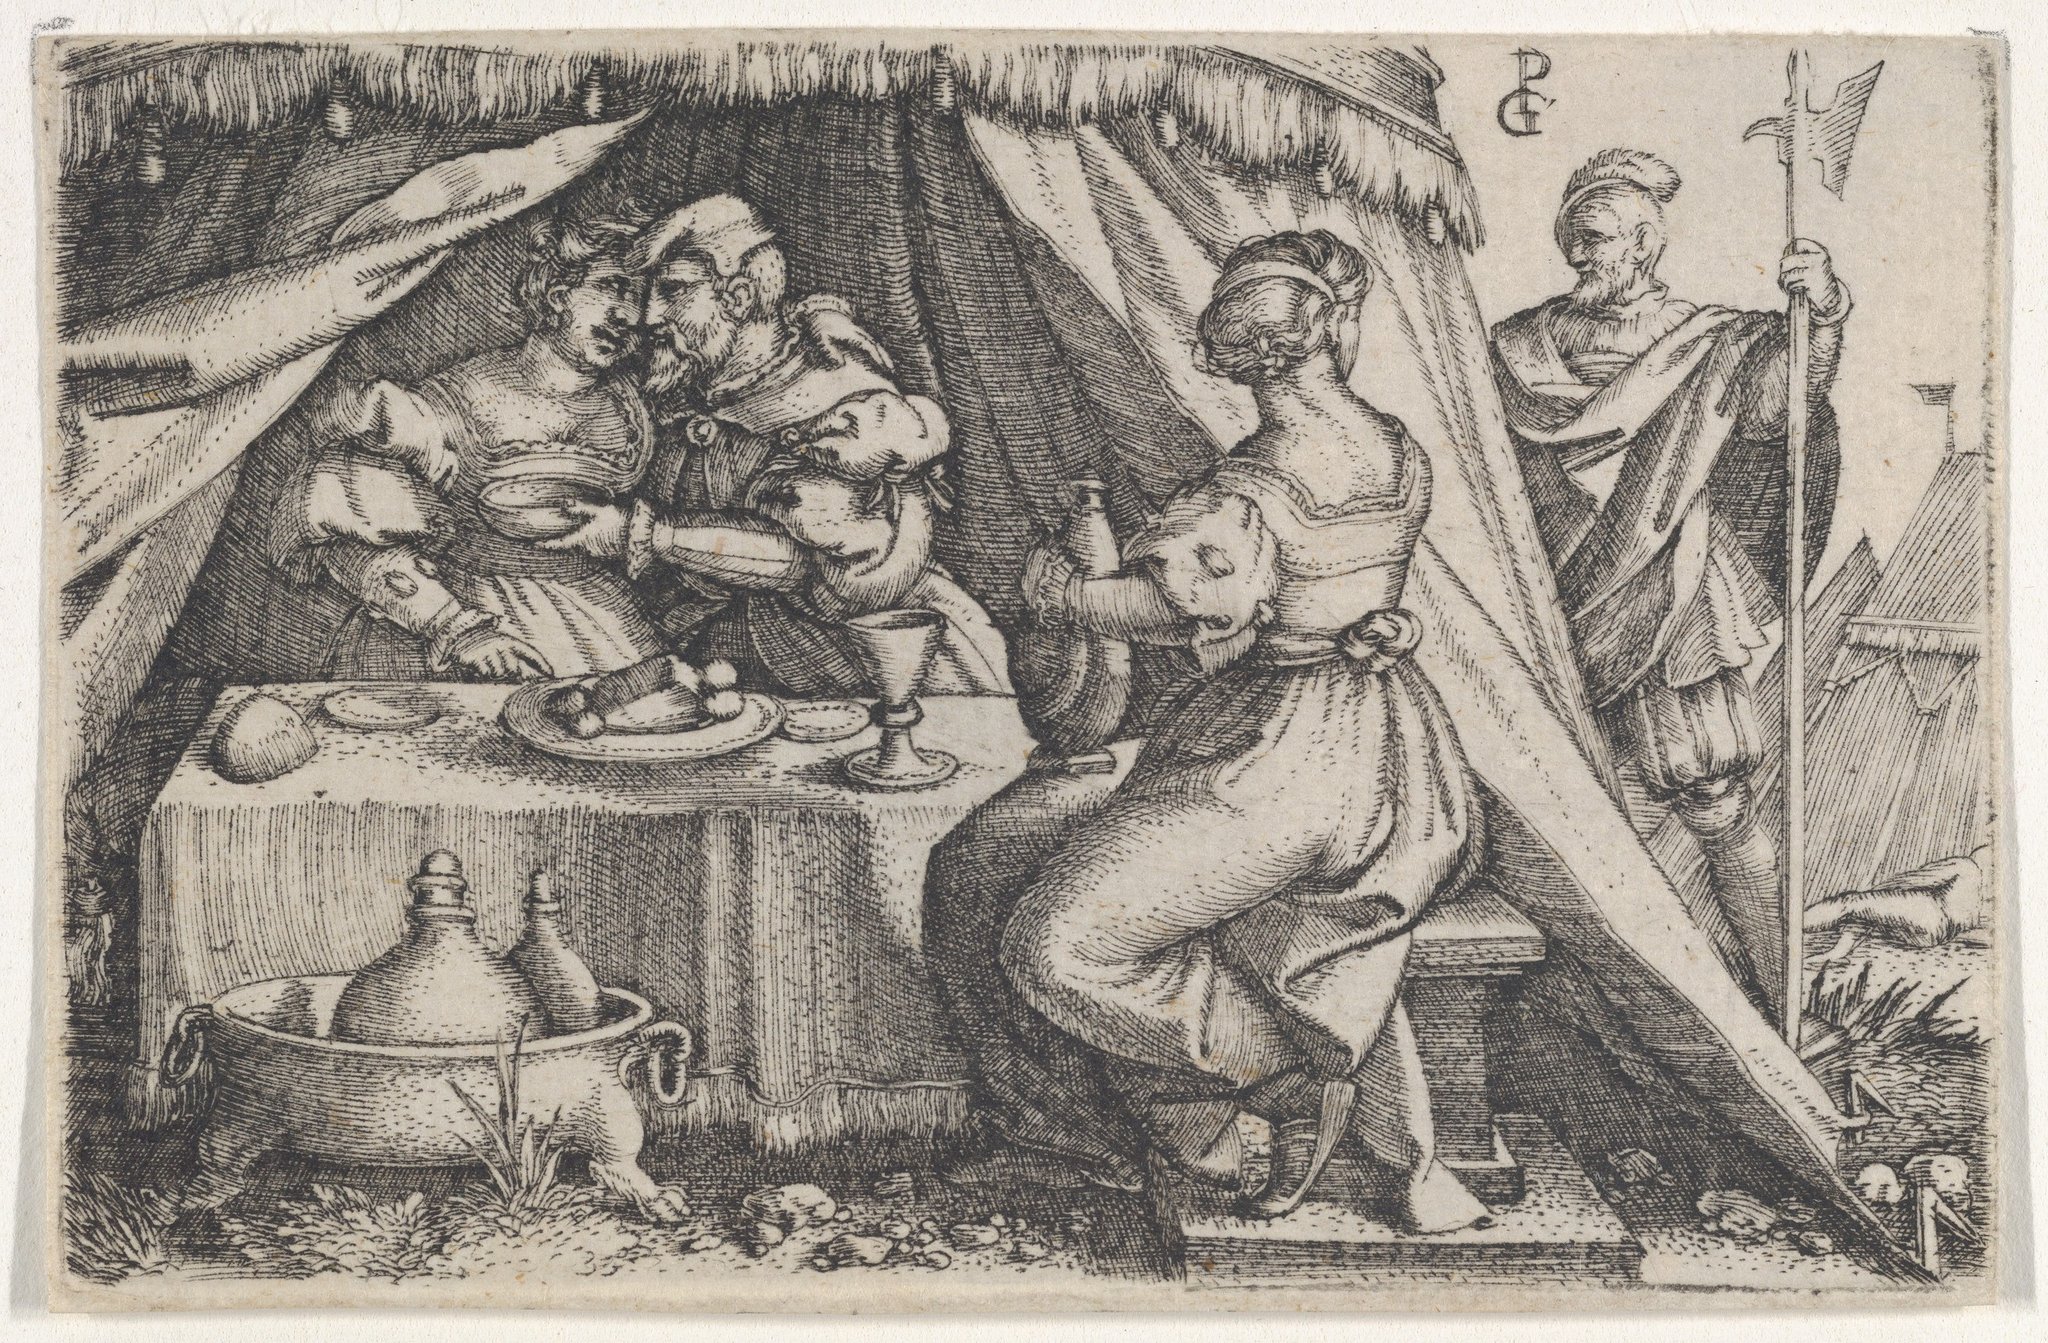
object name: print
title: Judith and Holofernes Dining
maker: georg pencz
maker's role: artist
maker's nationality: german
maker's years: 1500-1550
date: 1526-1536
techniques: engraving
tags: holofernes,judith,dining